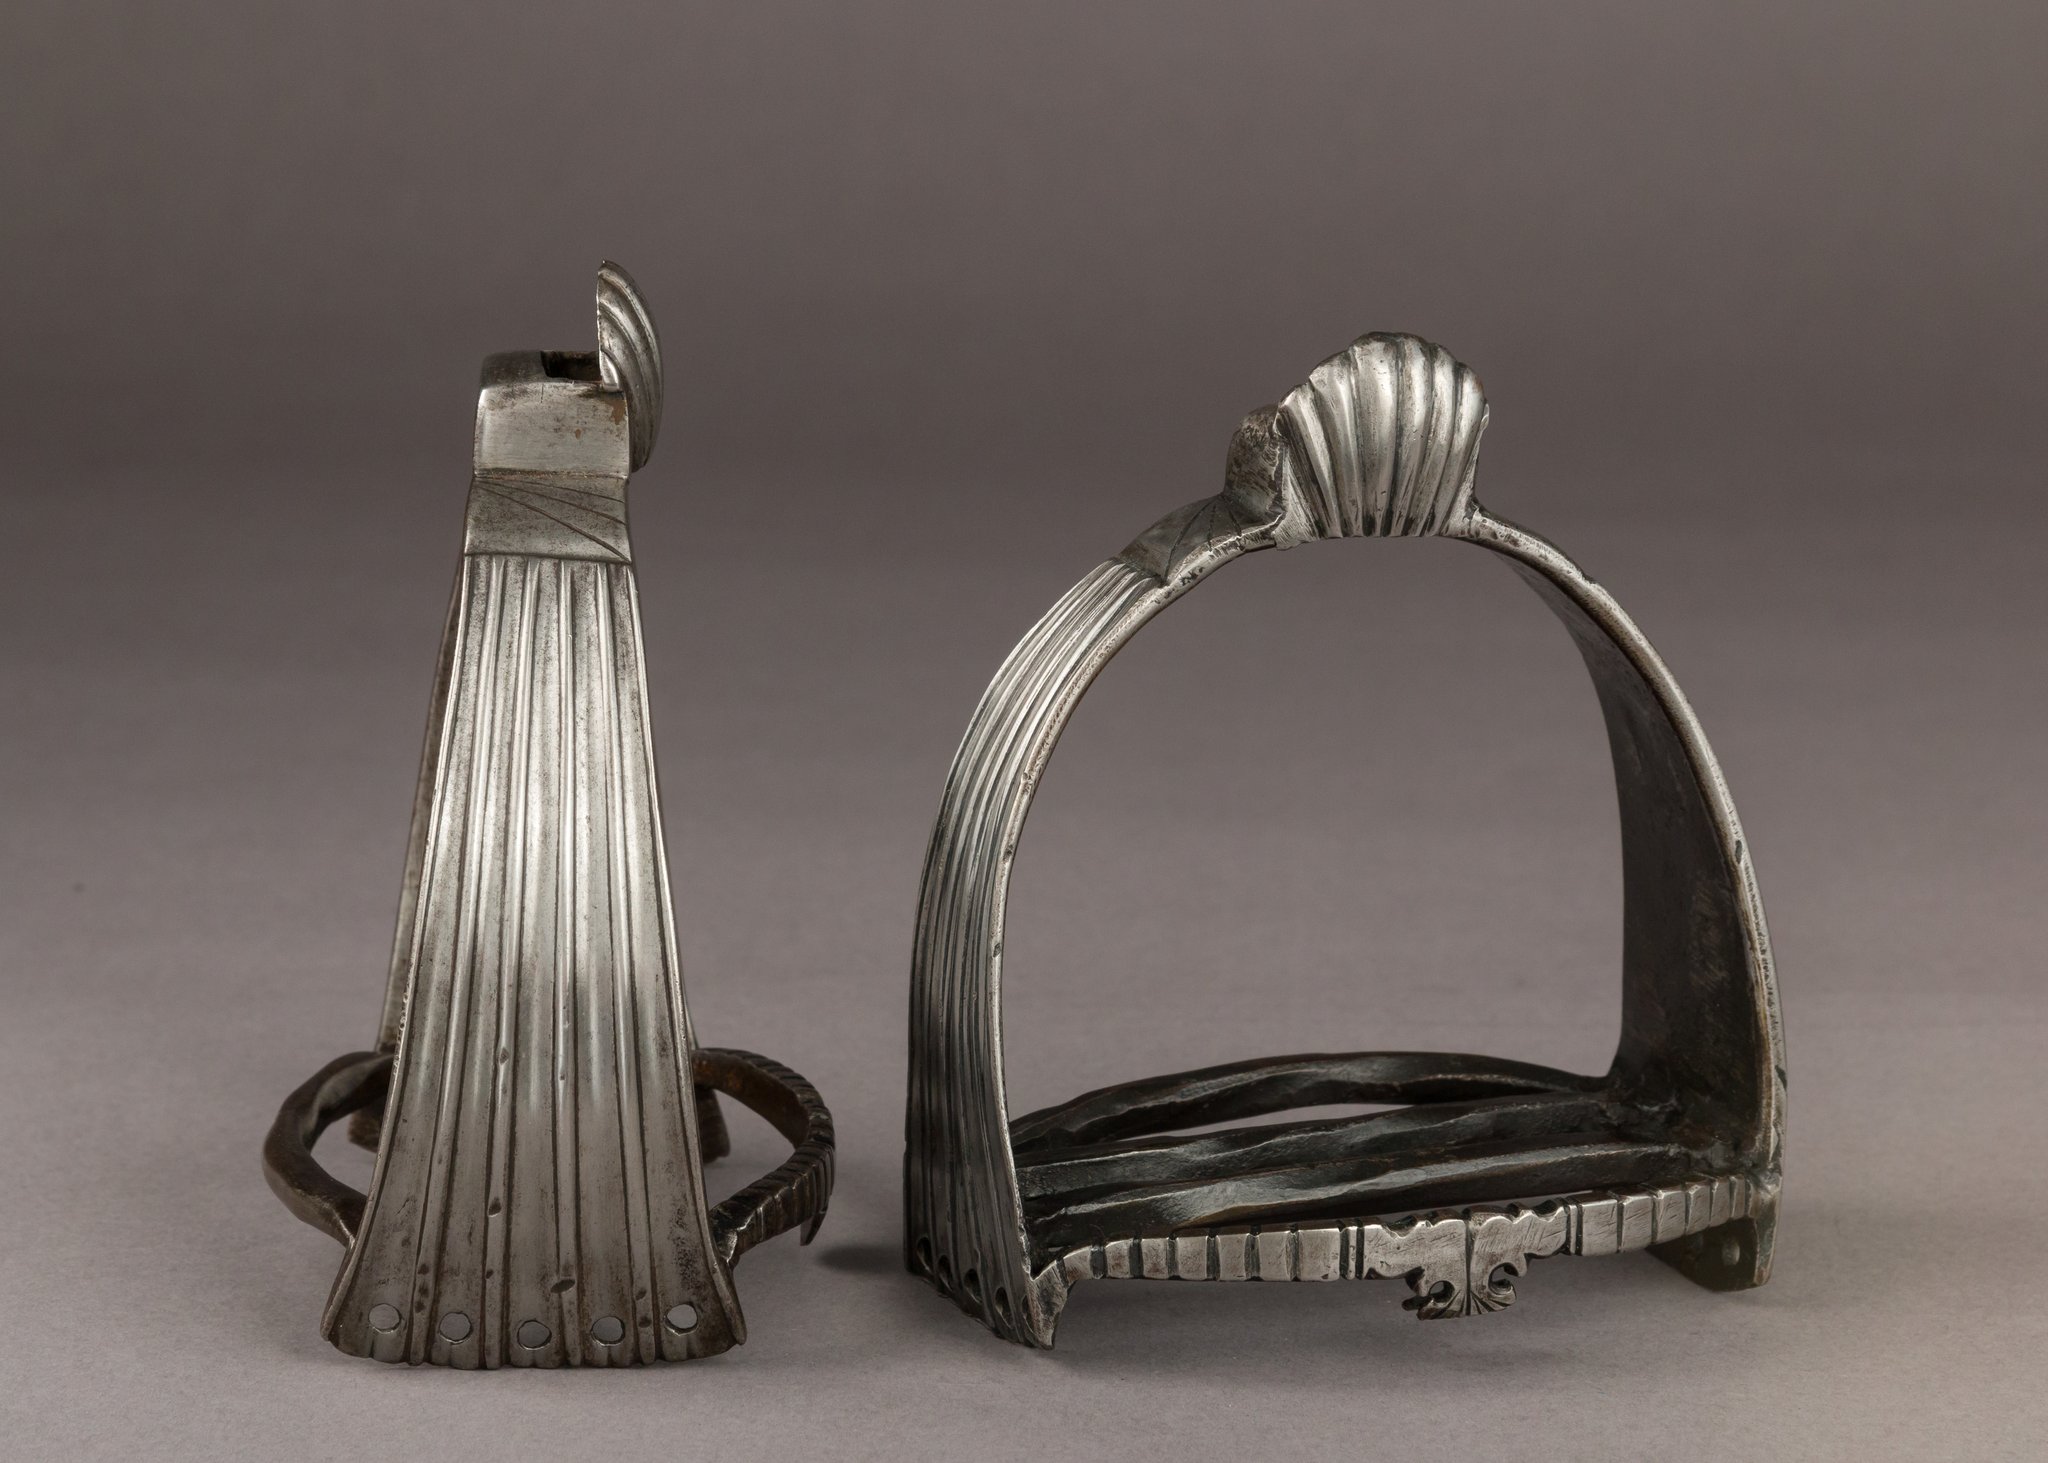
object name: saddle with stirrup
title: Saddle with Stirrups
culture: german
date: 1501-1600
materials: brass, leather, steel, wood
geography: germany